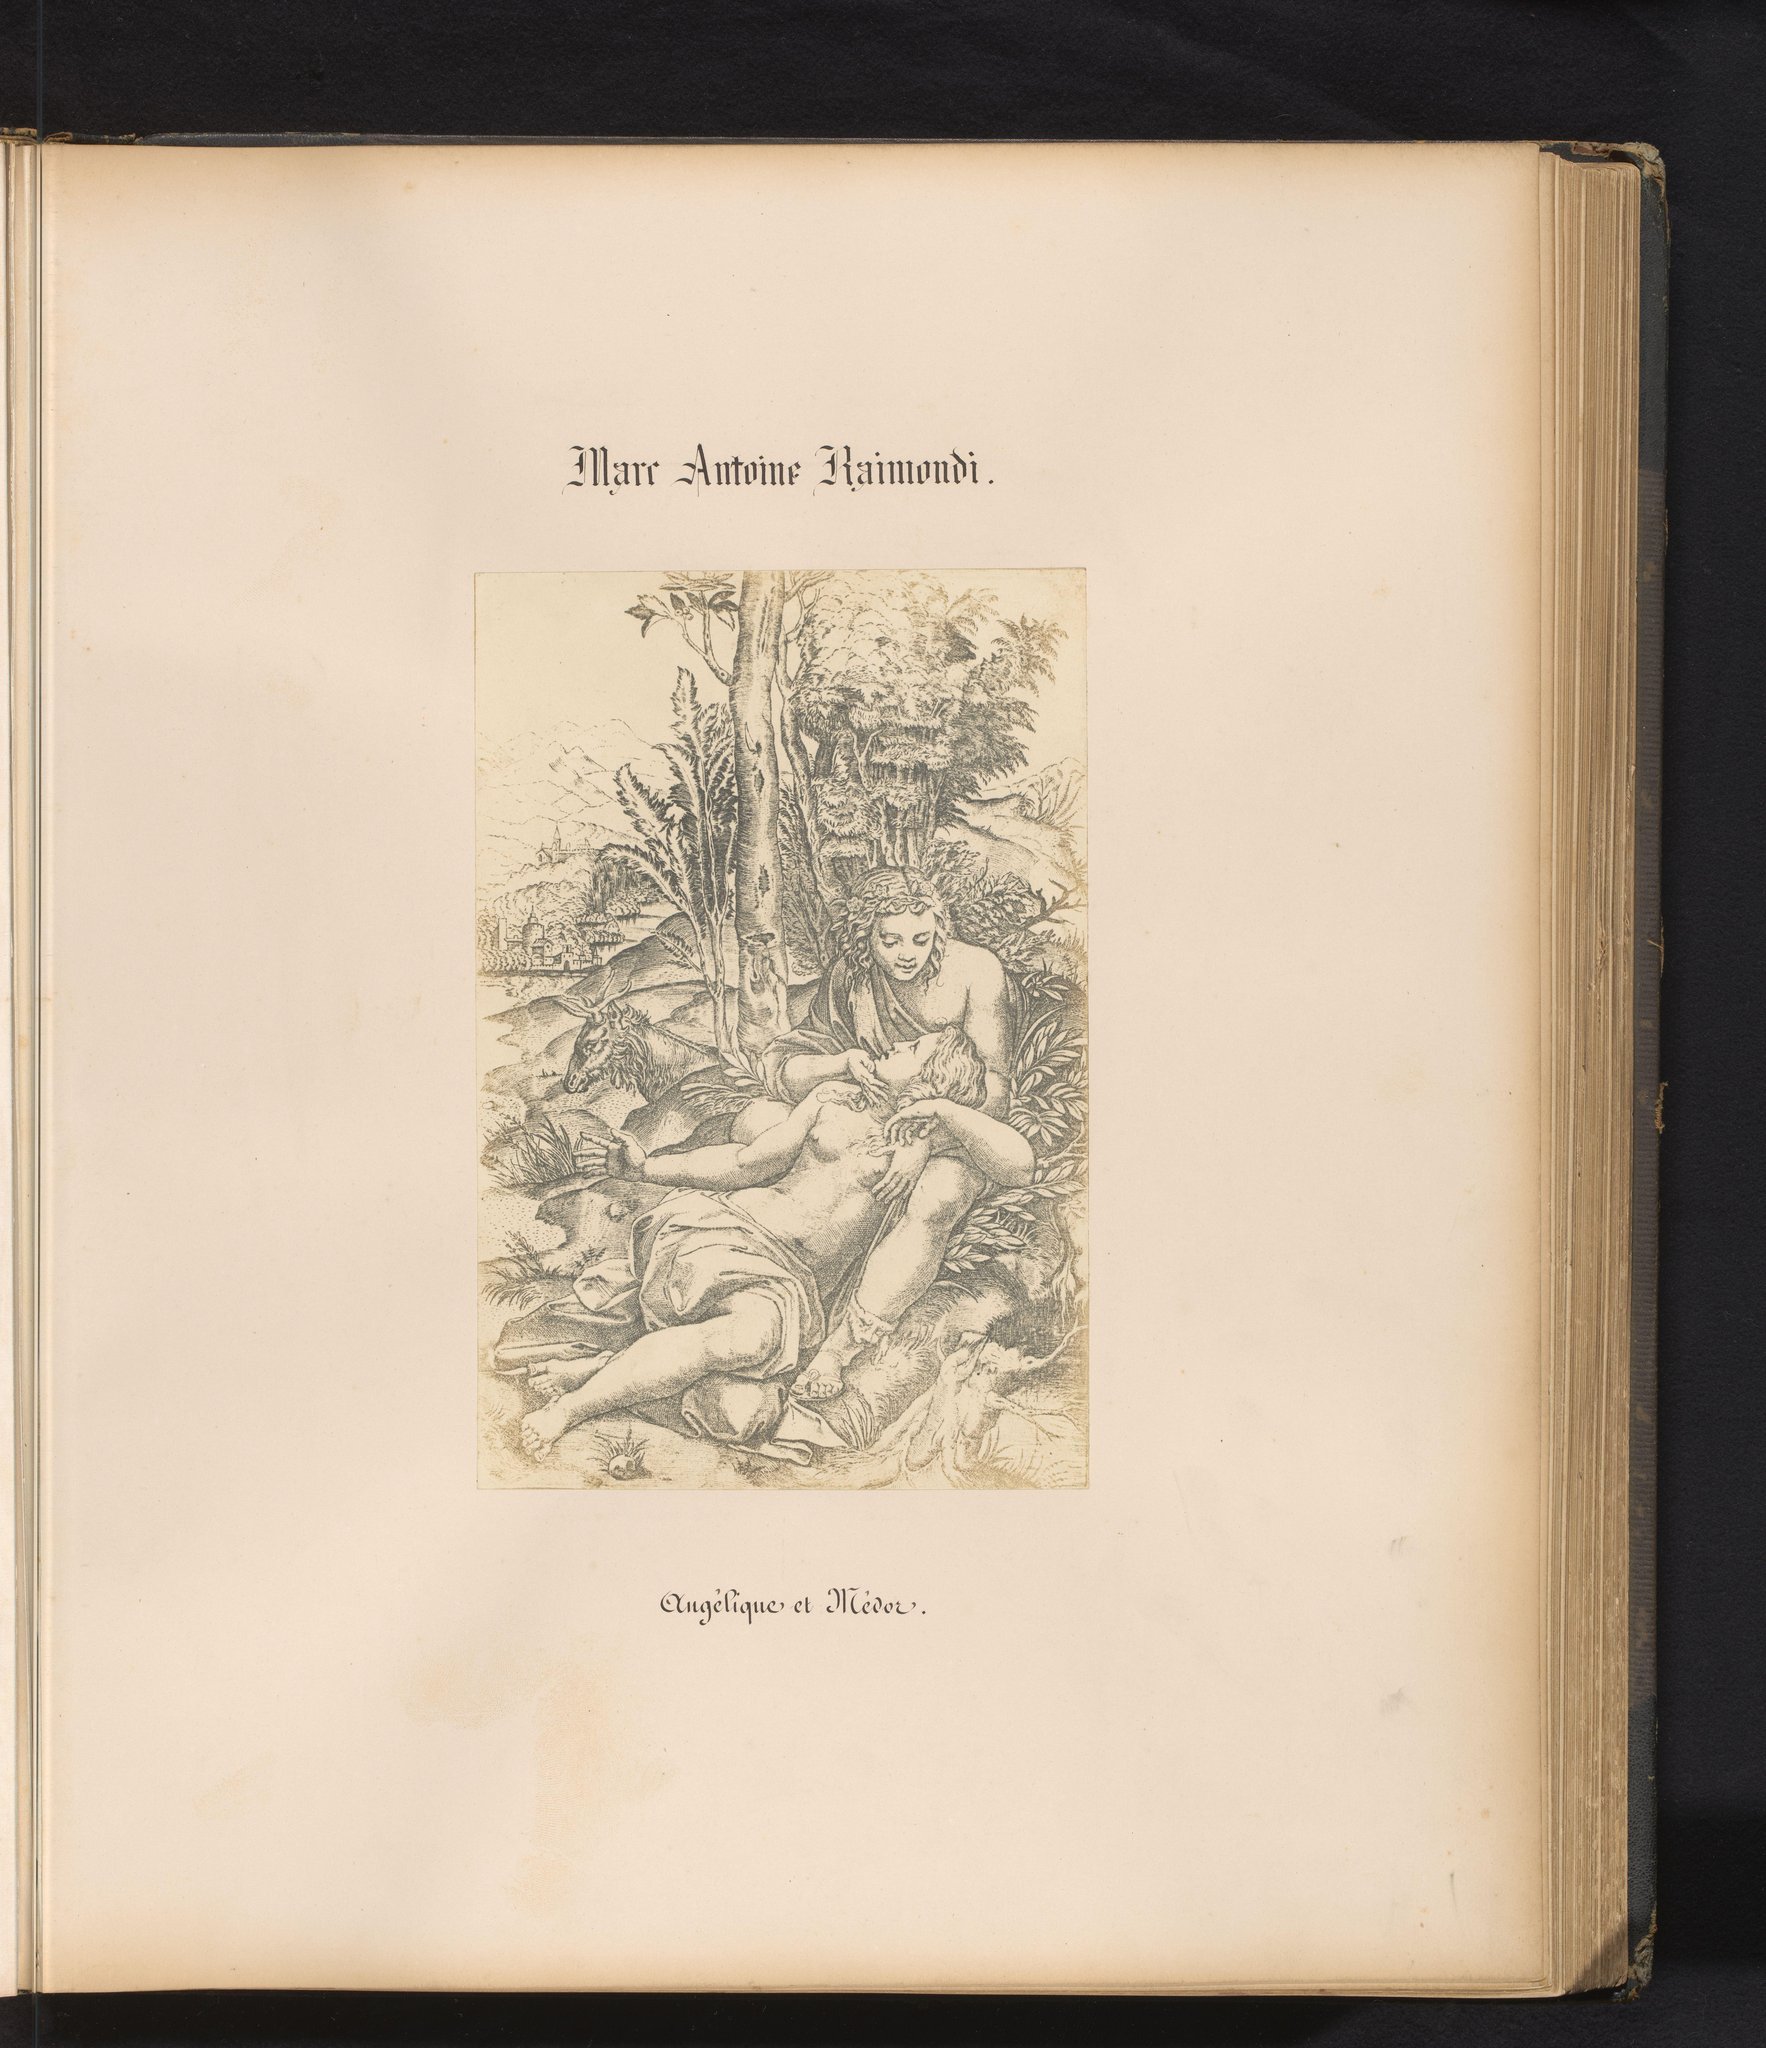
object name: page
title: Angélique et Médor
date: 1848-1853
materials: photographic support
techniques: salted paper print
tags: herding, herdsman, herdswoman, shepherd, shepherdess, cowherd, etc., angelica, couple of lovers